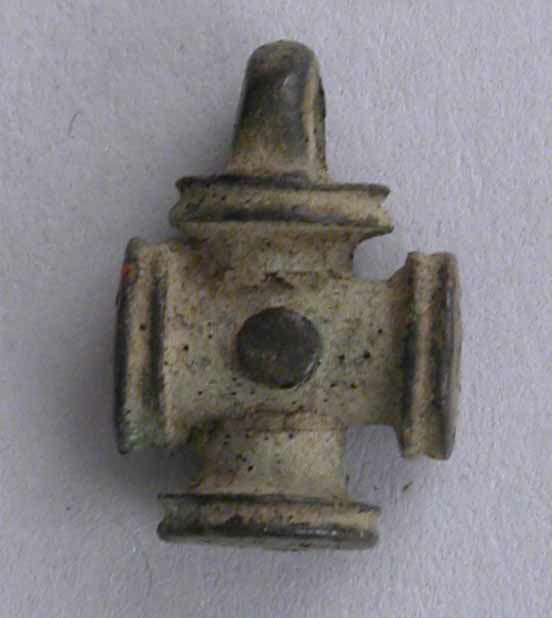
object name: cross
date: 201-1200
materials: wood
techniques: carving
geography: egypt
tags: cross